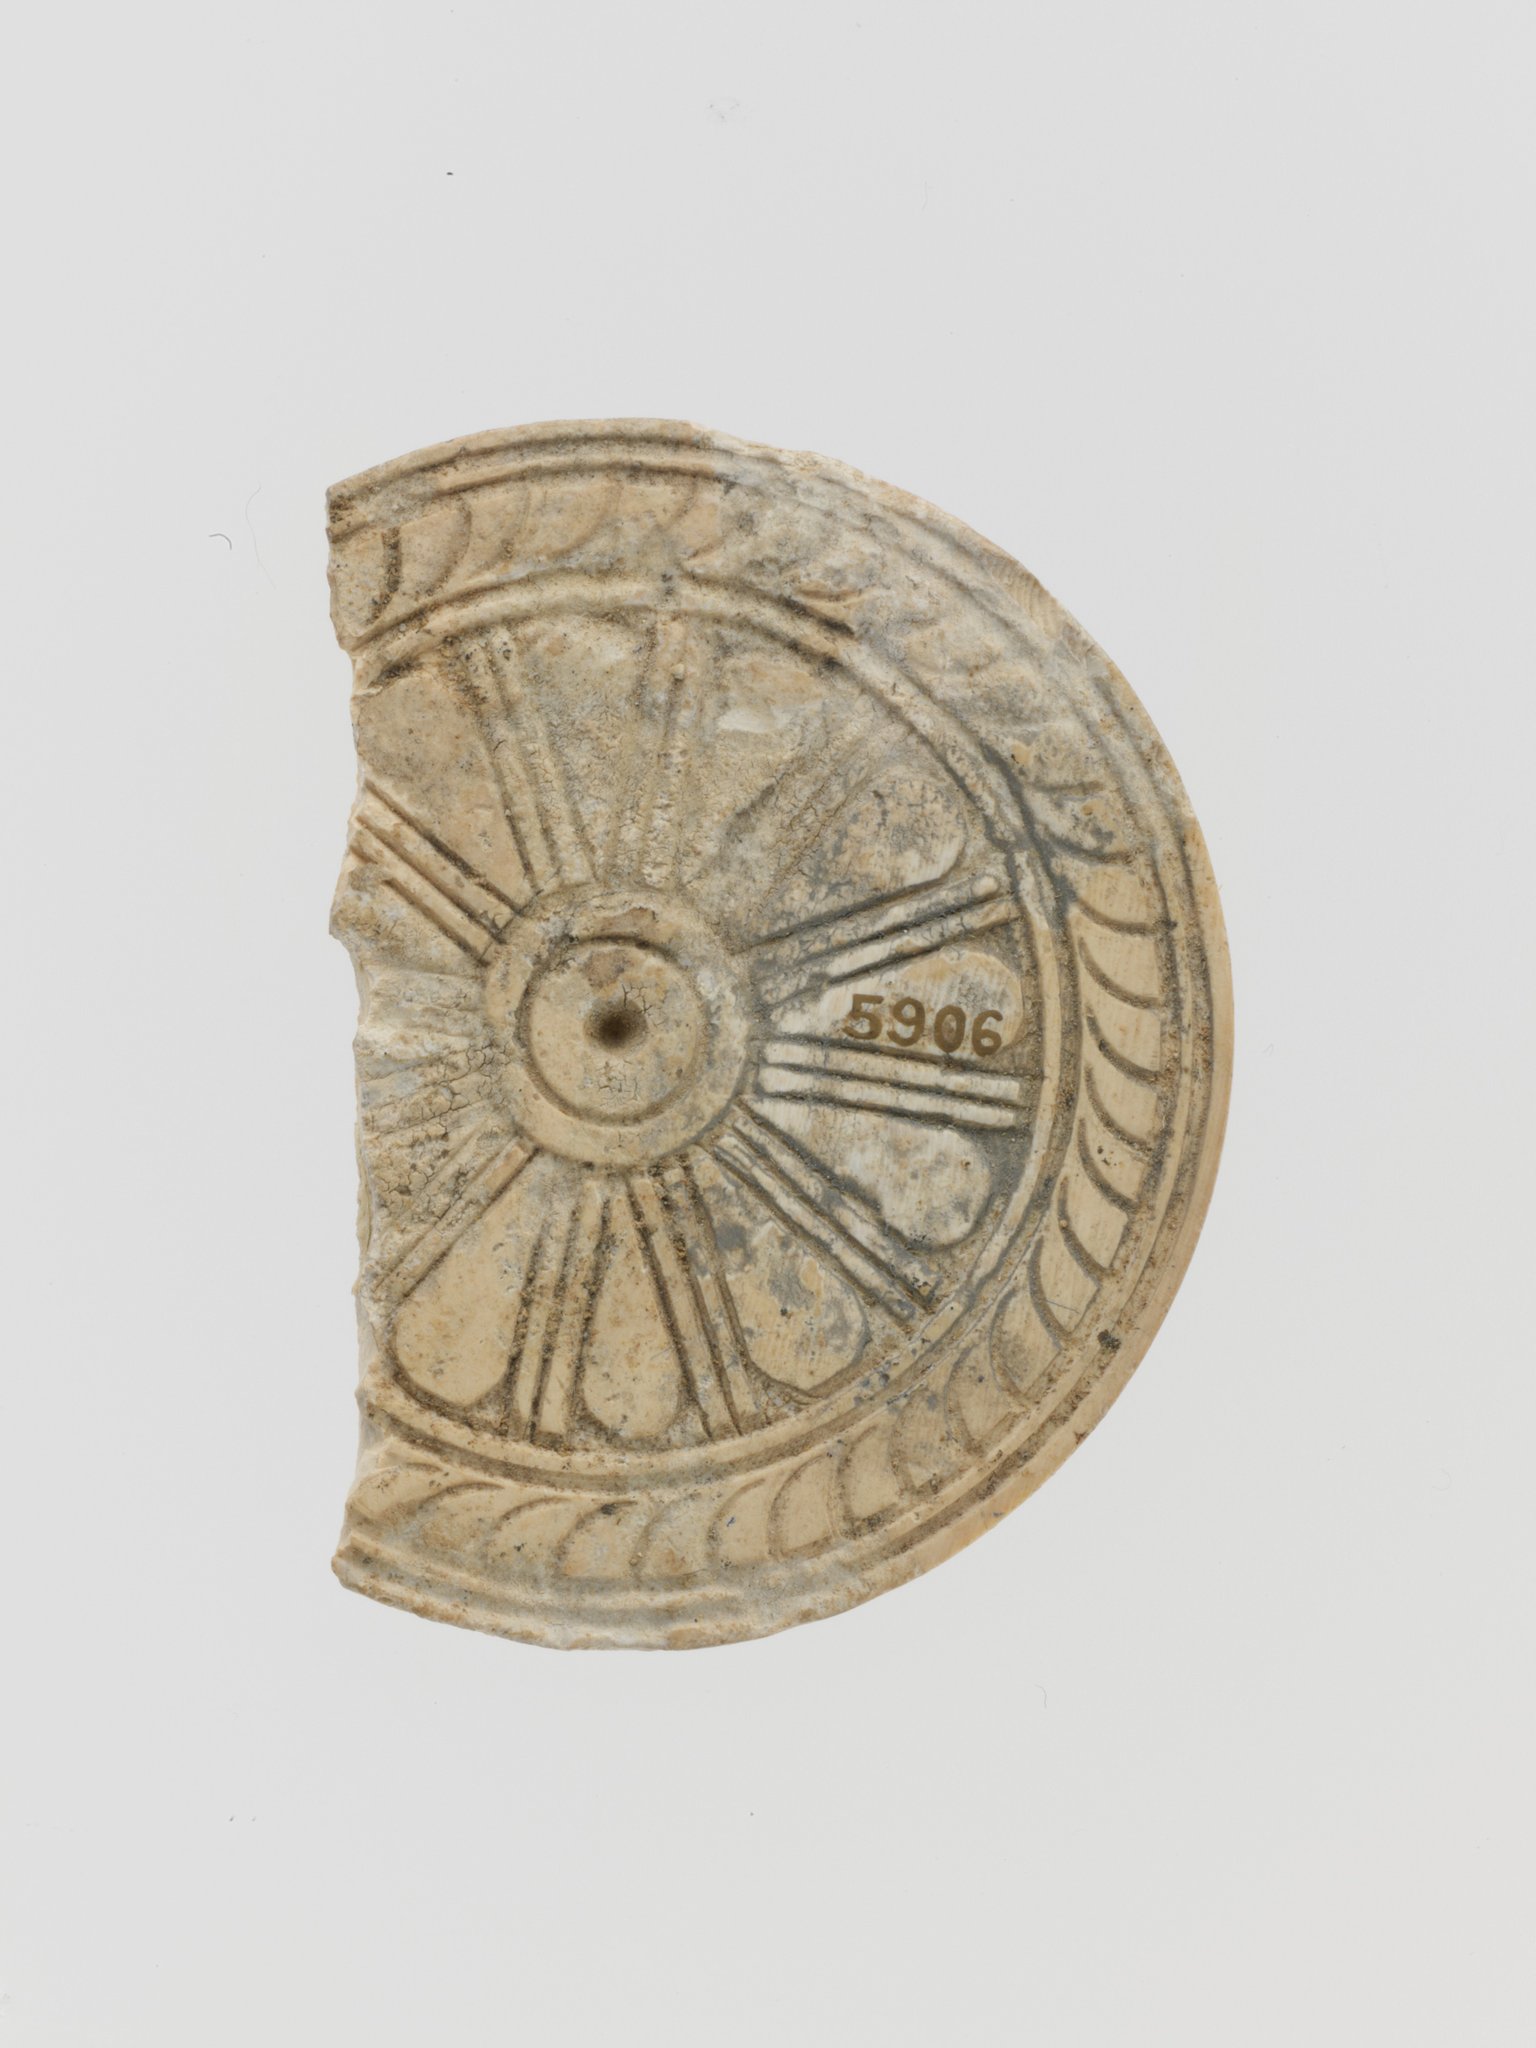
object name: roundel, disk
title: Ivory disk of a pyxis with rosette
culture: cypriot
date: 1300-1101 BCE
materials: ivory